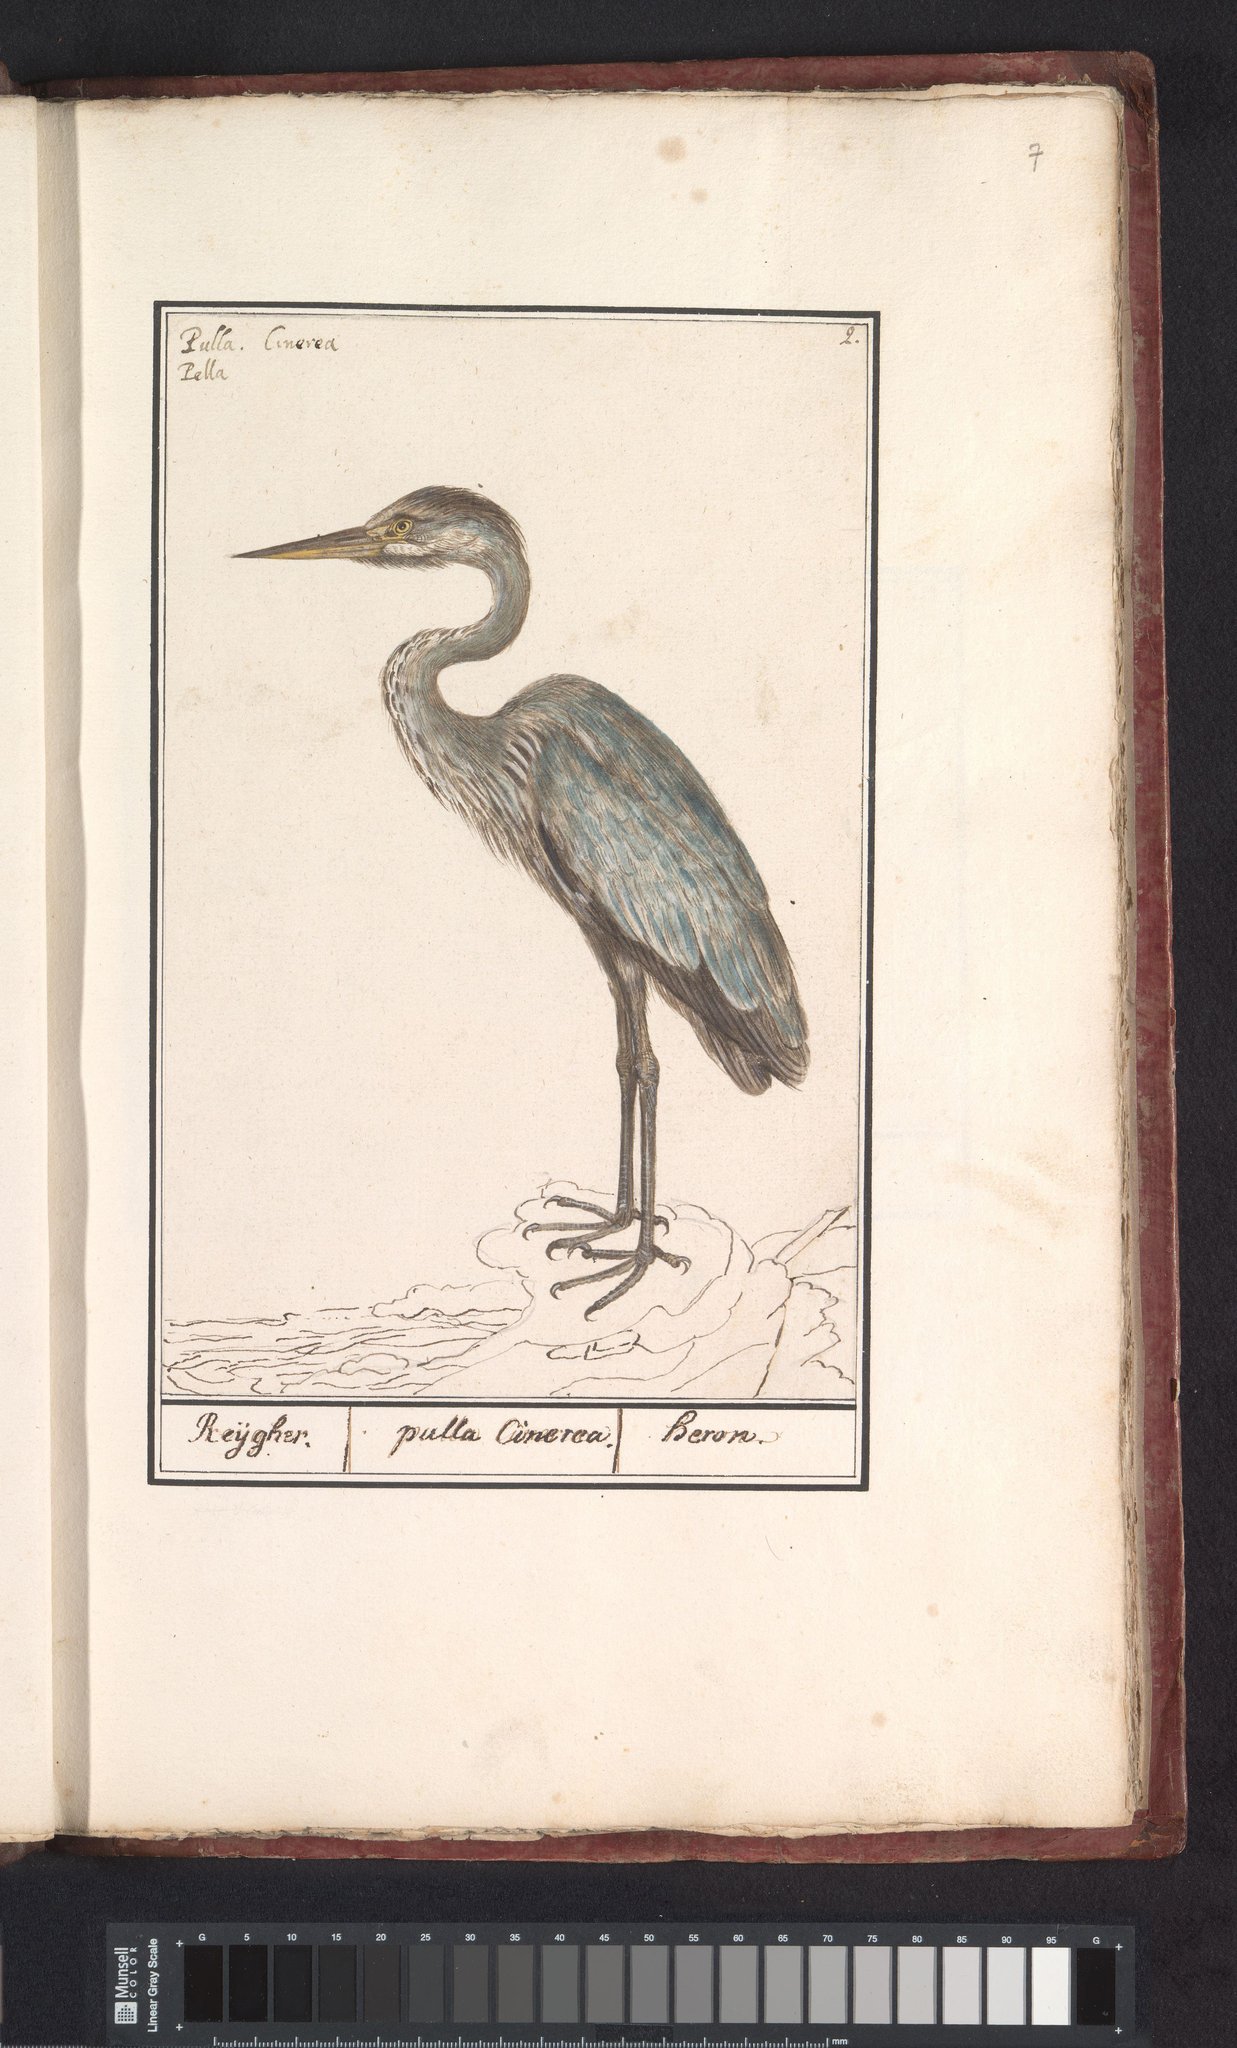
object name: drawing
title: Blauwe reiger (Ardea cinerea)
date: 1596-1610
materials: paint, ink, paper, pencil, watercolor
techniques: brush, pen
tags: shore-birds and wading-birds: heron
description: Blauwe reiger. Genummerd rechtsboven: 2. Linksboven de Latijnse naam. Onderdeel van het derde album met tekeningen van vogels. Vijfde van twaalf albums met tekeningen van dieren, vogels en planten bekend rond 1600, gemaakt in opdracht van keizer Rudolf II. Met toelichting in Nederlands, Latijn en Frans.